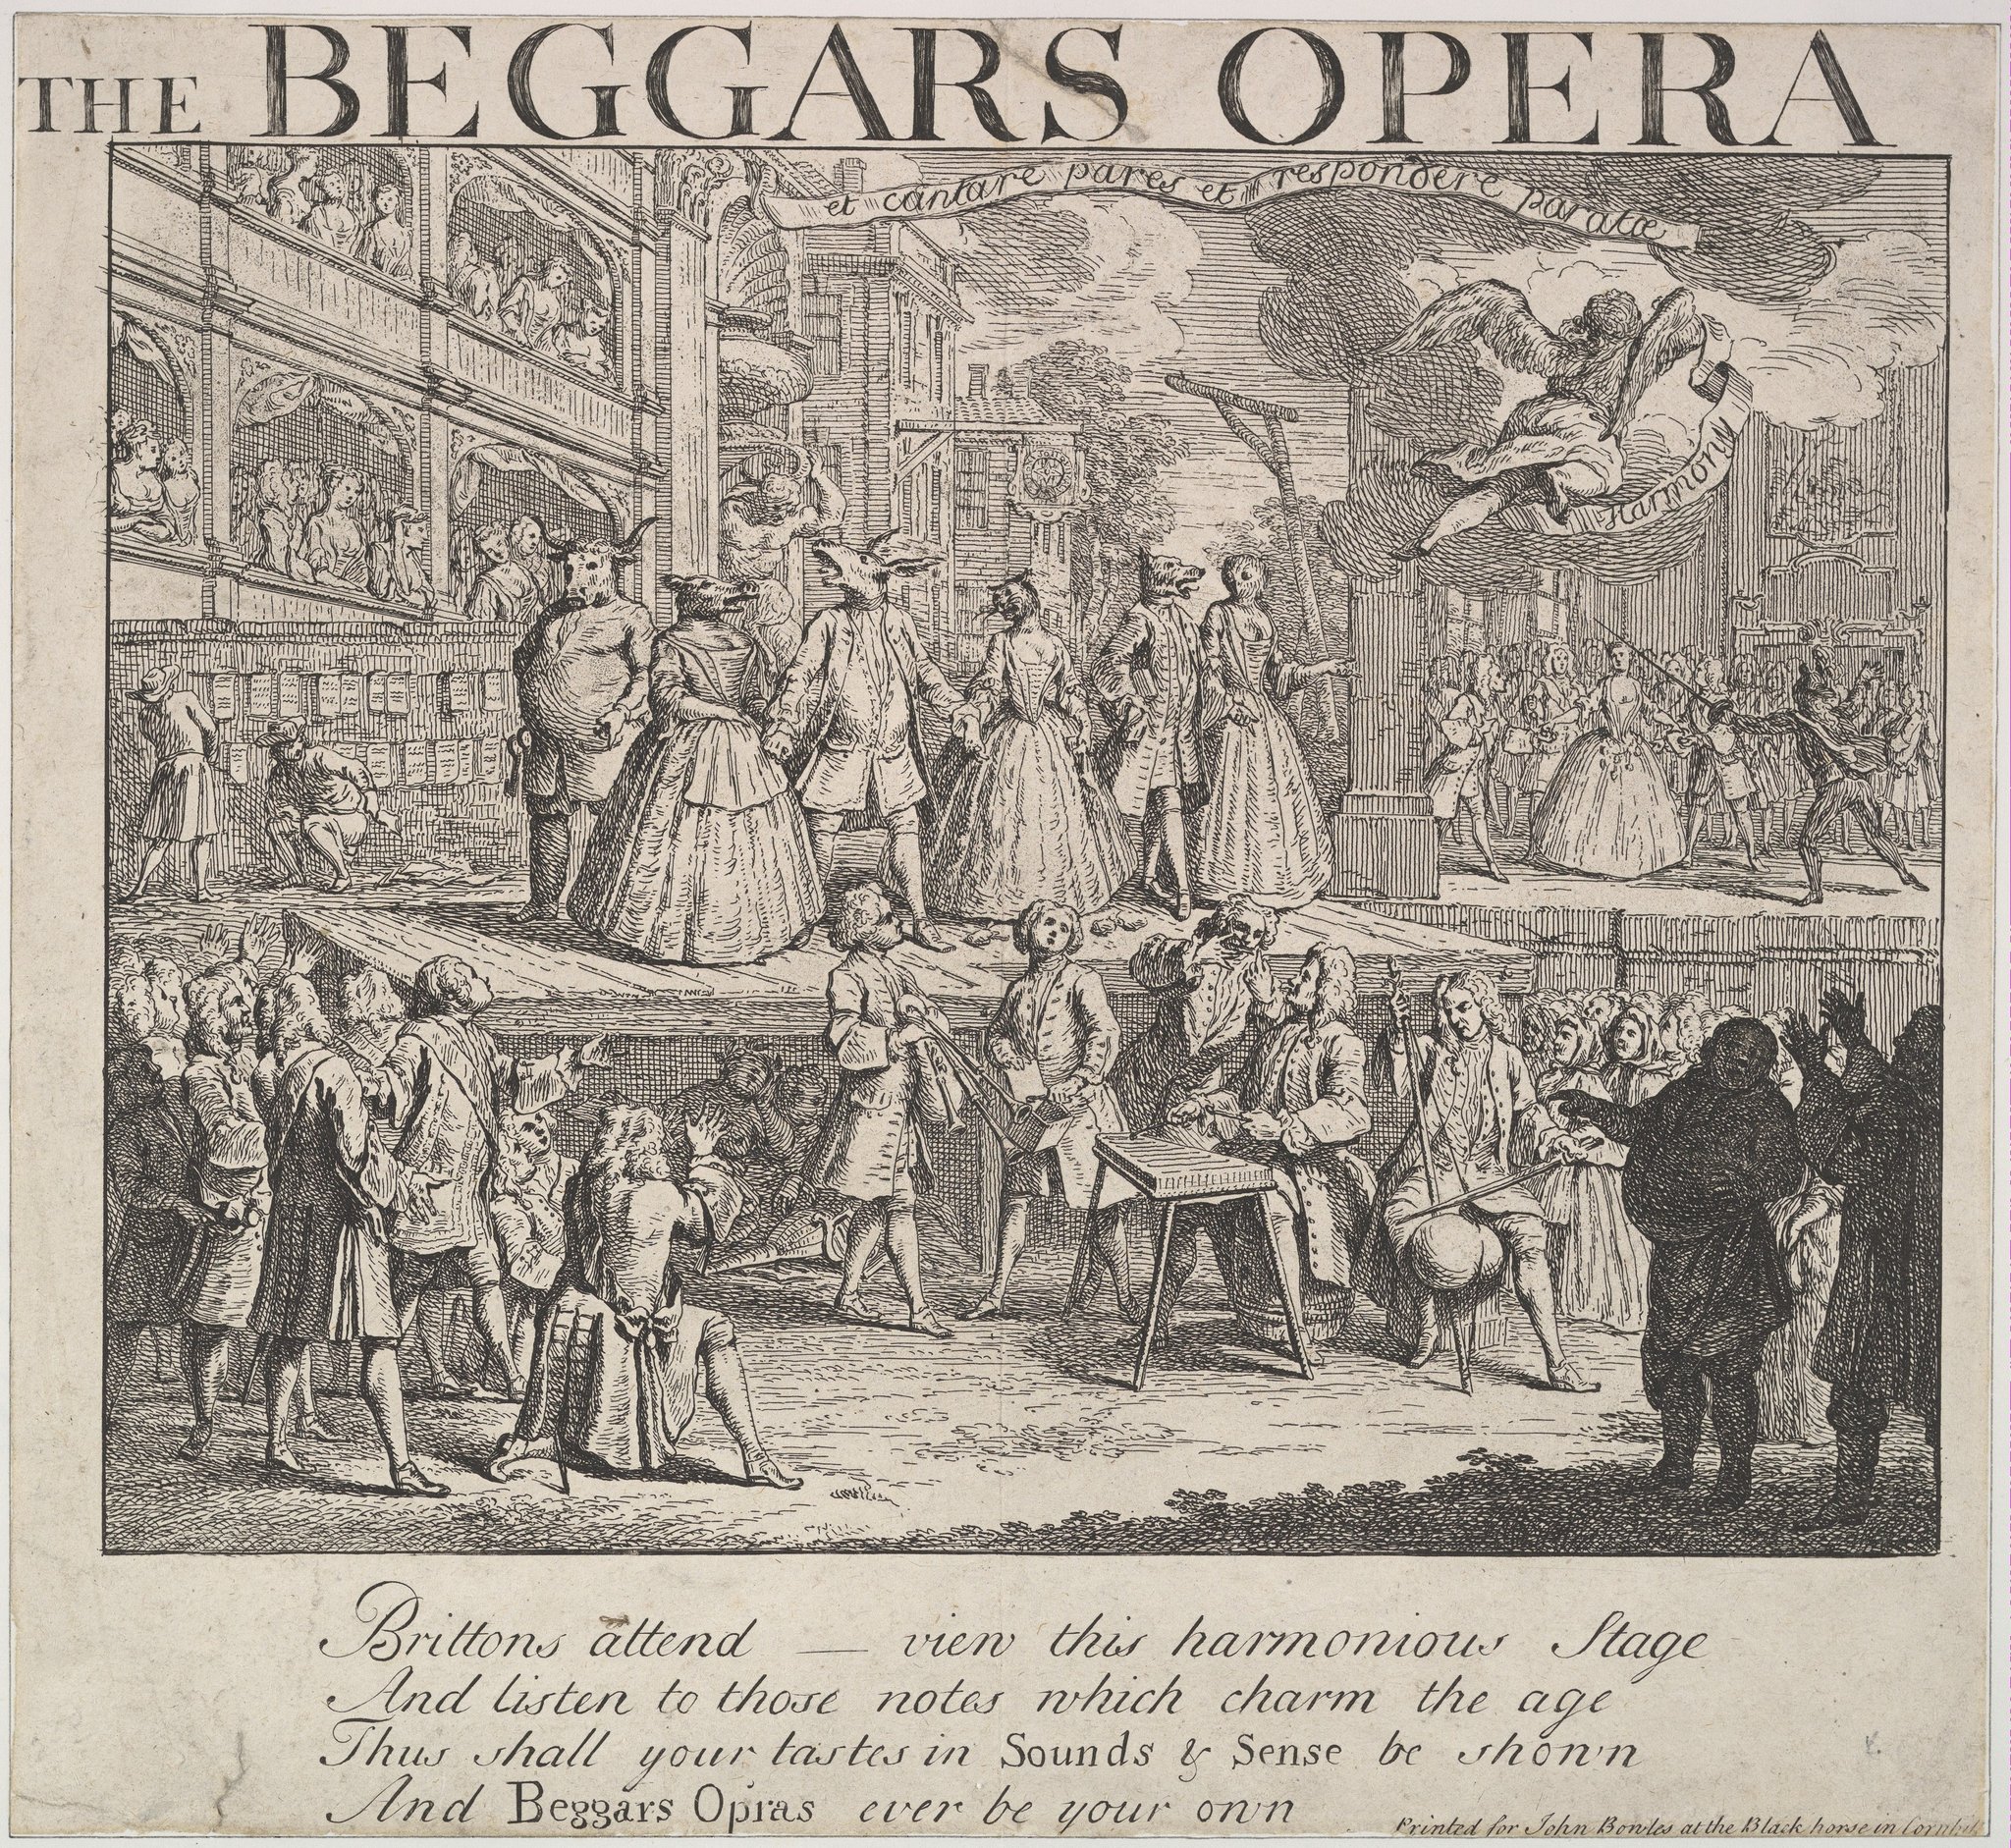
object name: print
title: The Beggars Opera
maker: anonymous, british, 18th century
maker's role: artist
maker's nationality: british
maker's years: 1700-1800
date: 1728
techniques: etching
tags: musical instruments,opera,men,women,spectators